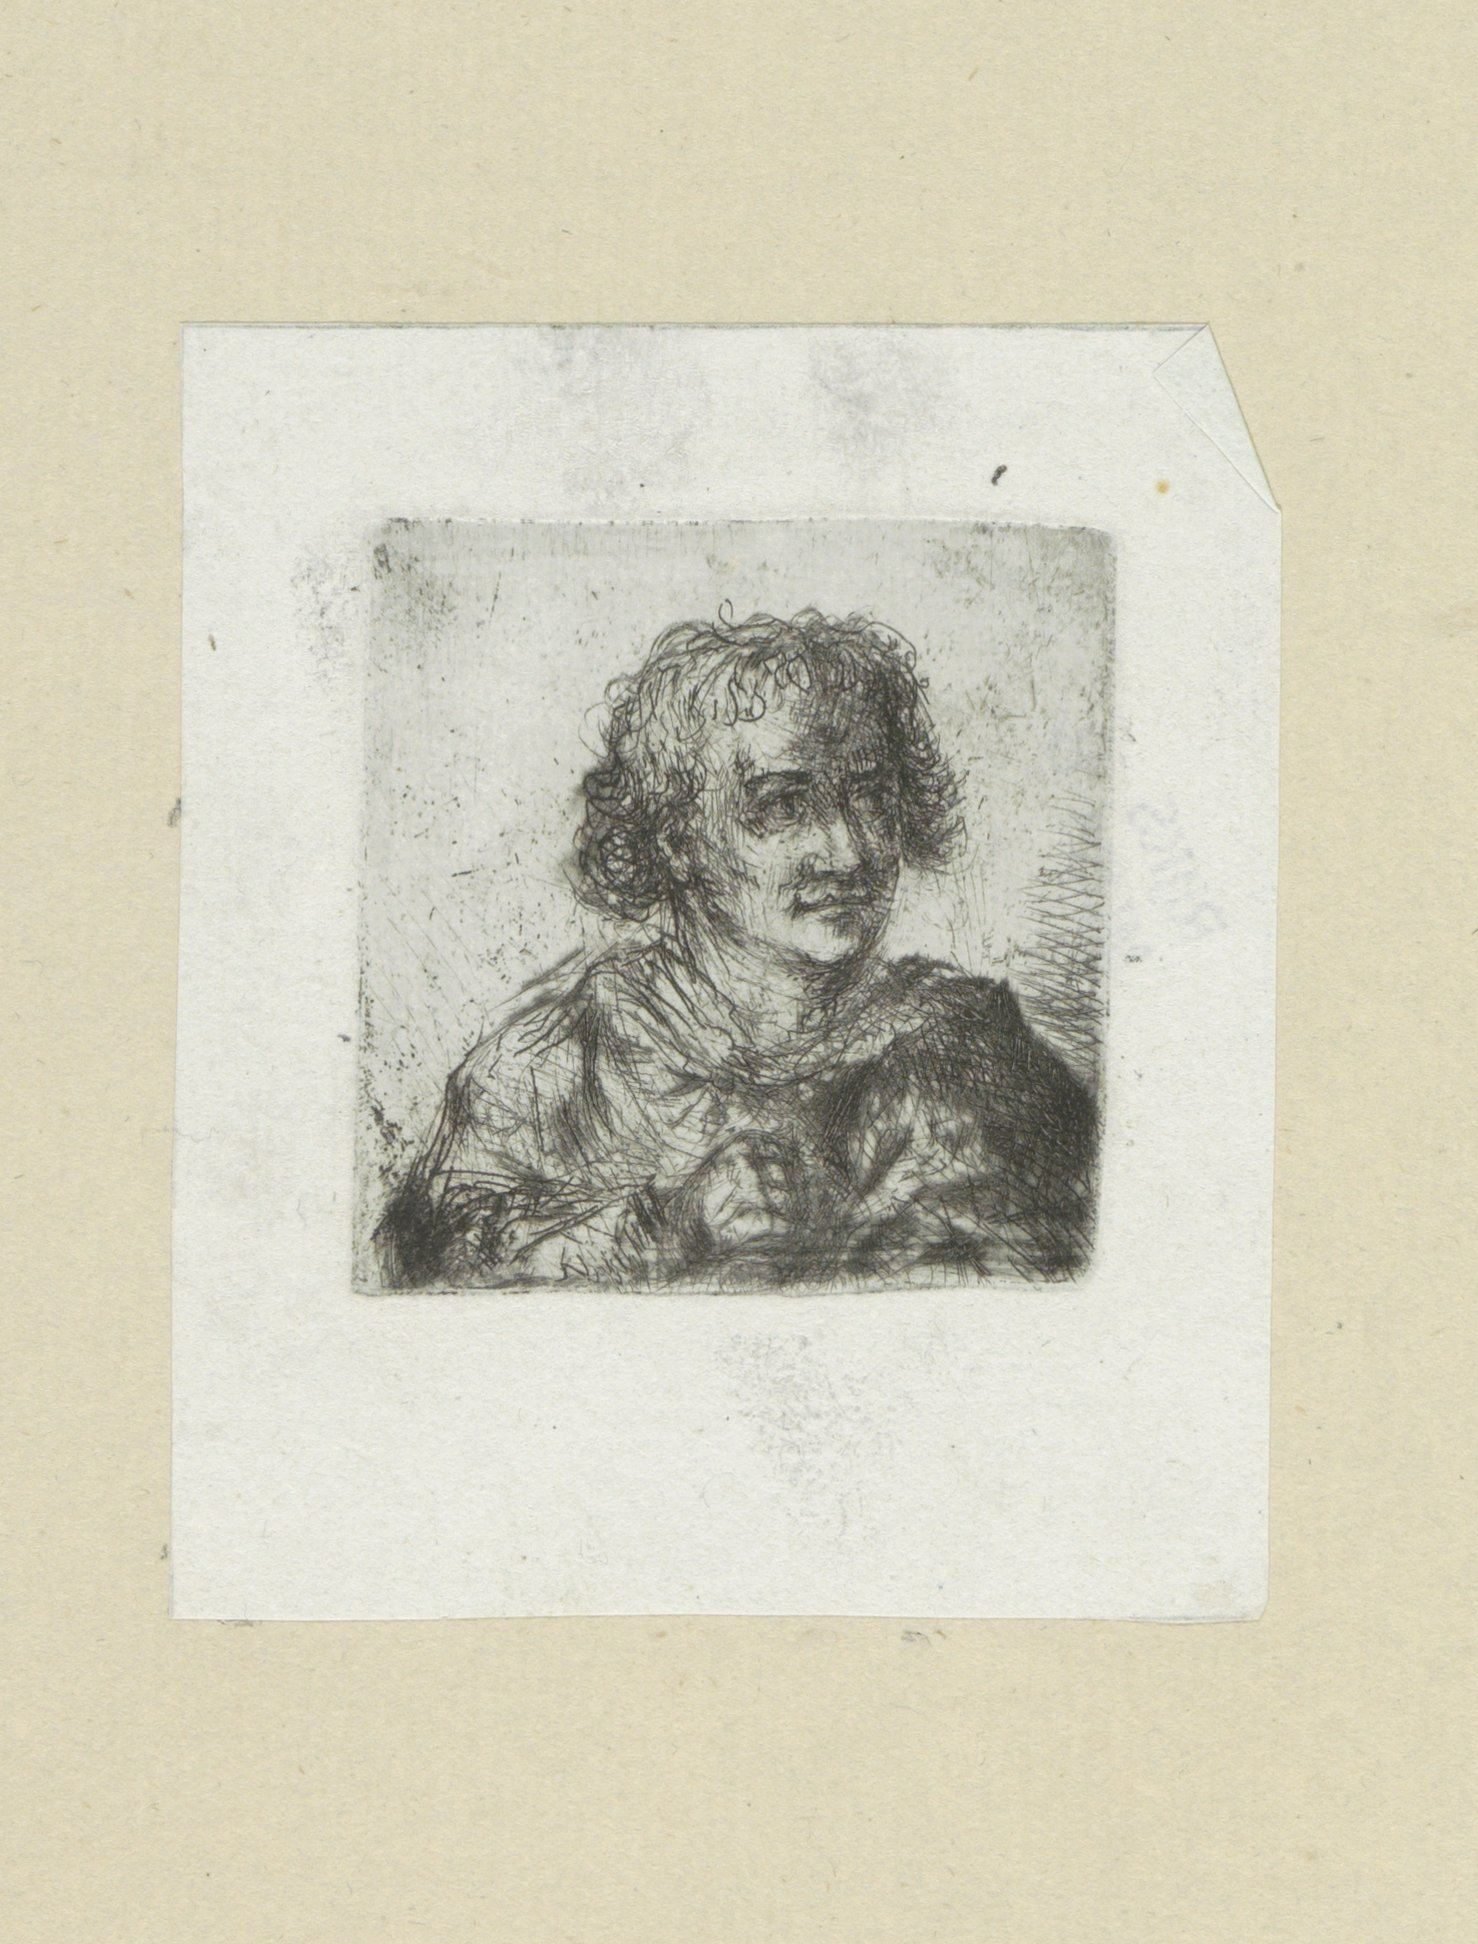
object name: album leaf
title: Volwassen man, zijn rechterhand zichtbaar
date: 1802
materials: paper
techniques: drypoint, etching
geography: london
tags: morphology of human expression (+ adult male (human being))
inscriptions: collector's mark: ‘B’, collector's mark: ‘RIJKS / MUSM’